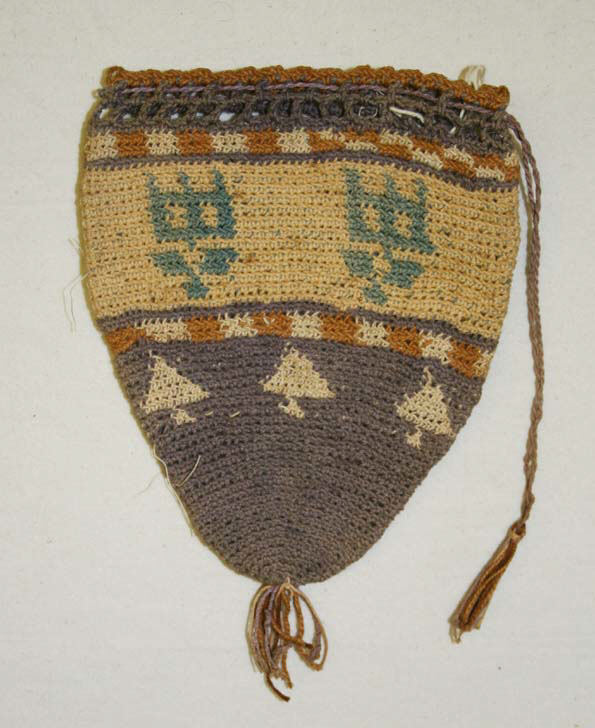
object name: bag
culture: european, eastern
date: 1801-1900